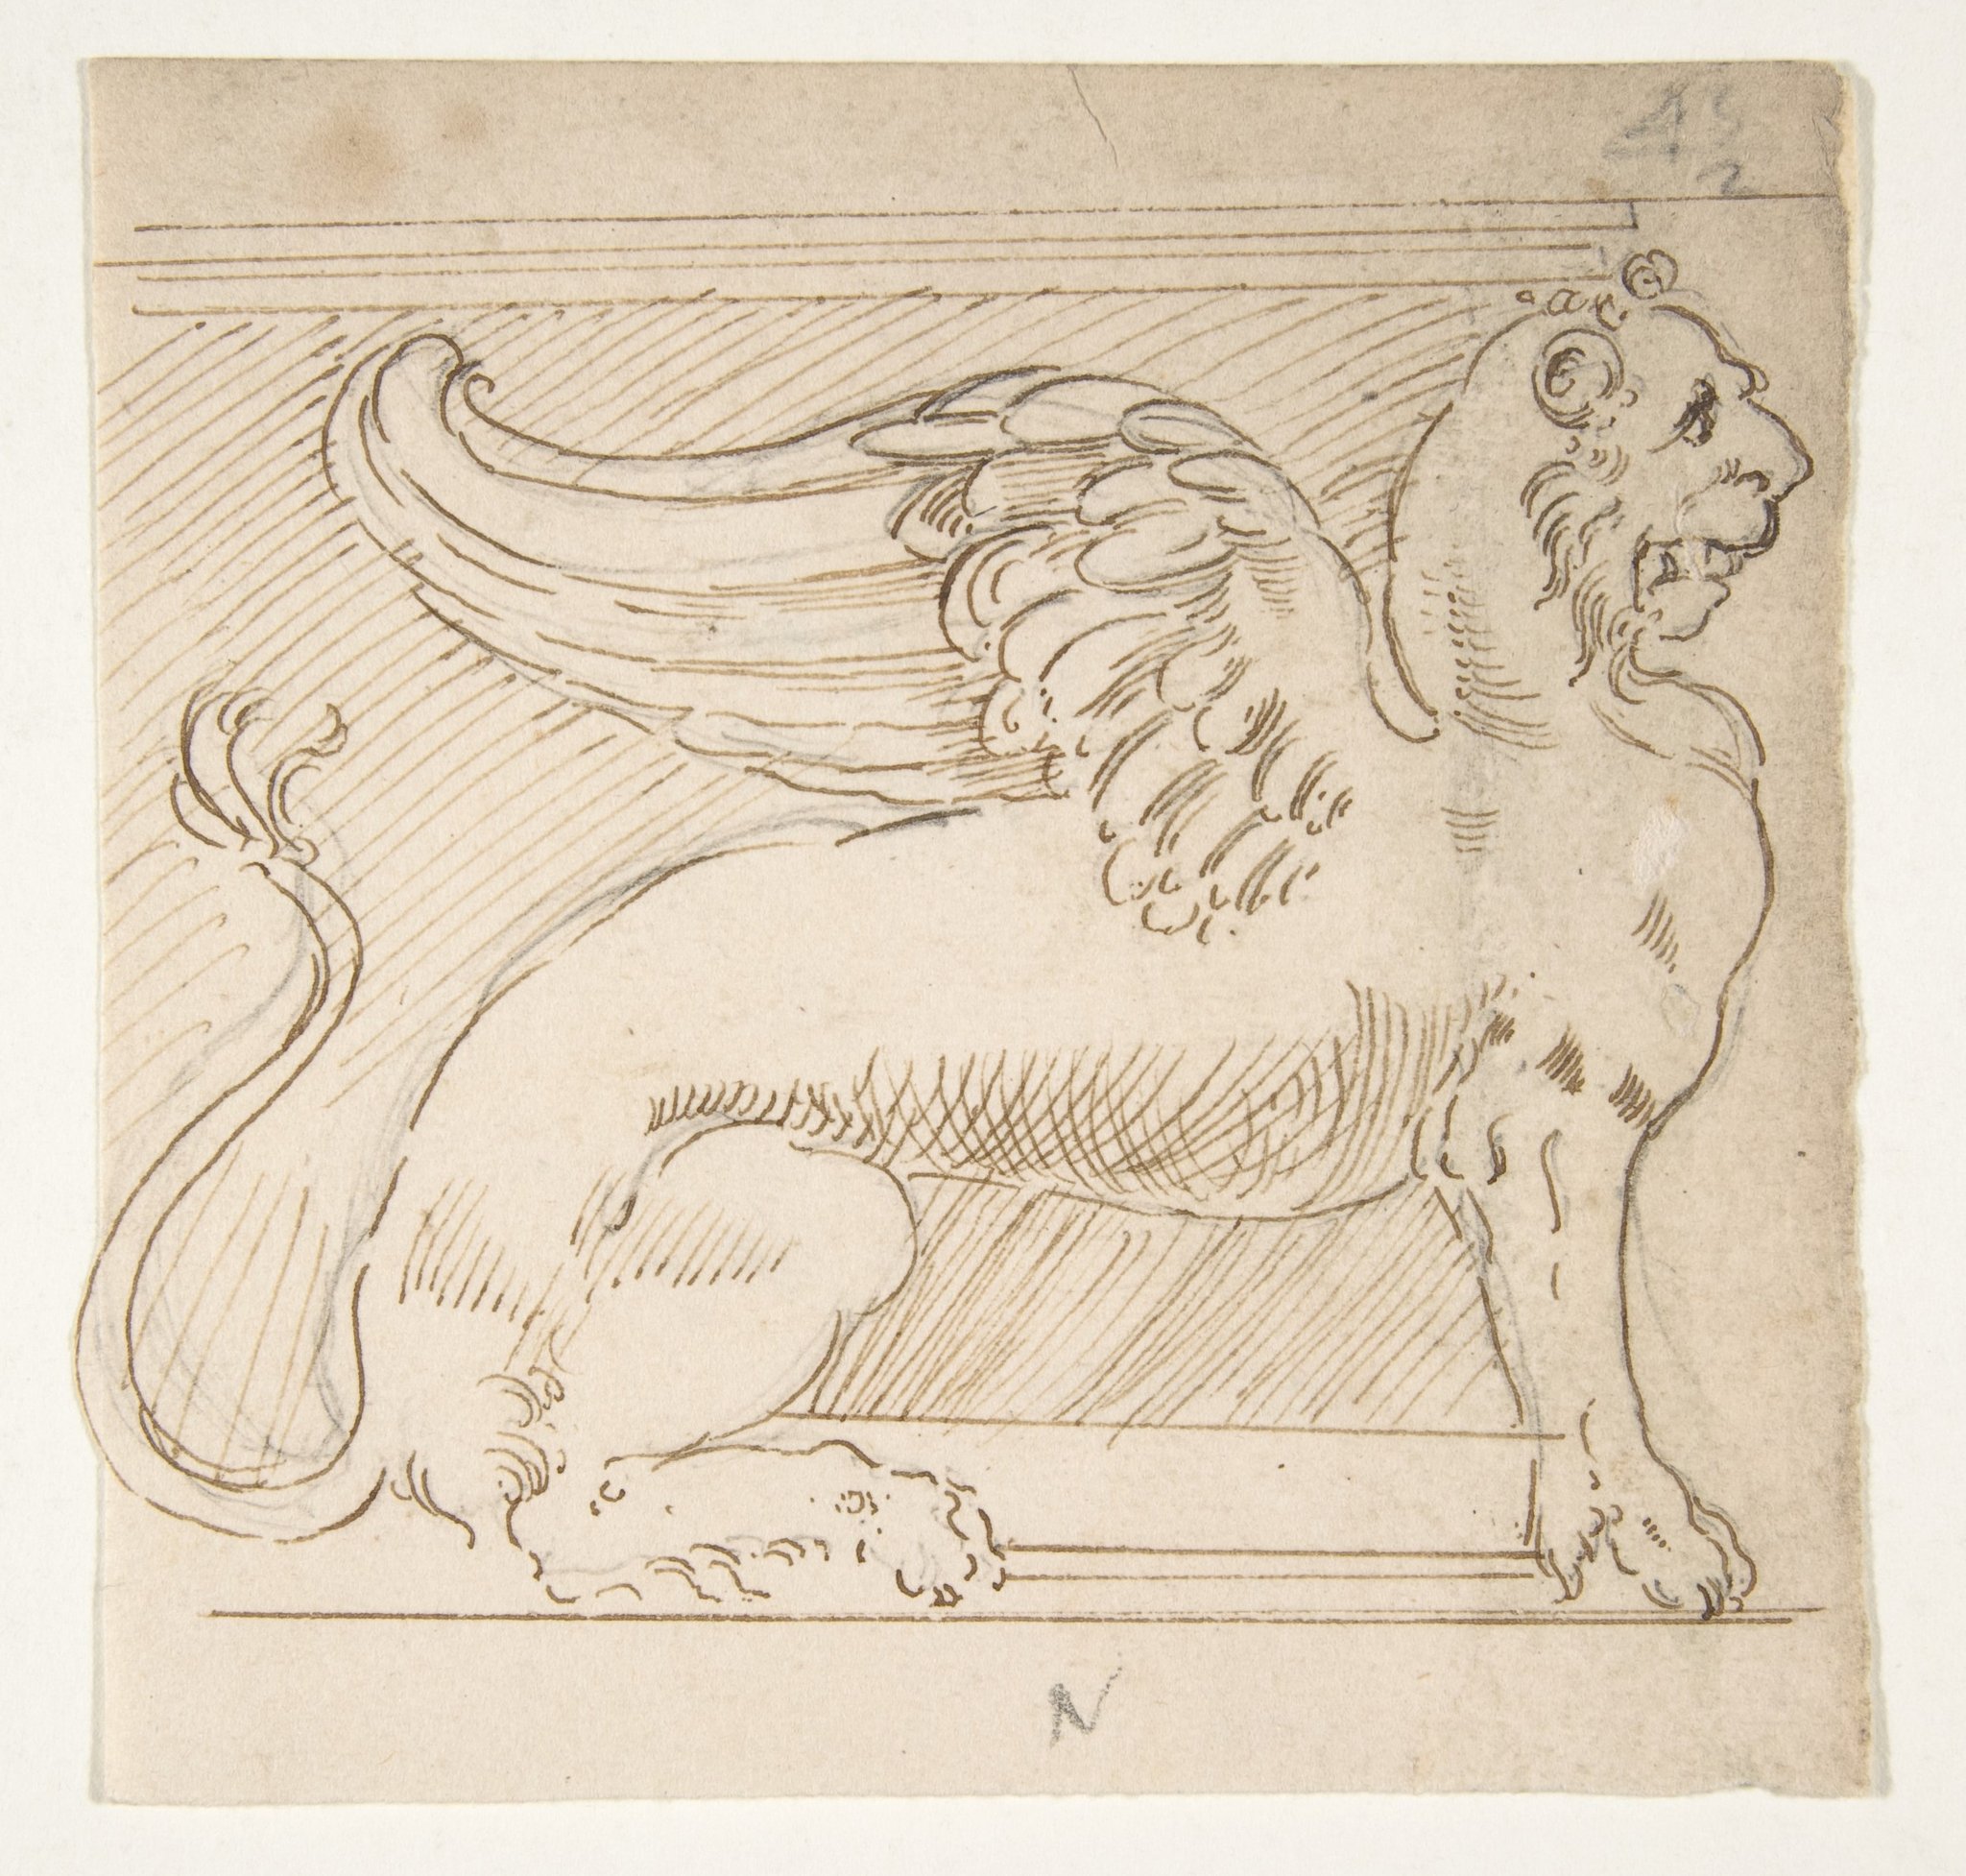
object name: collection ornament architecture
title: Unidentified, furniture support with winged lion motif, elevation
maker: anonymous, french, 16th century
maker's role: draftsman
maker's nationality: french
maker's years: 1500-1600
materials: chalk, ink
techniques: incising